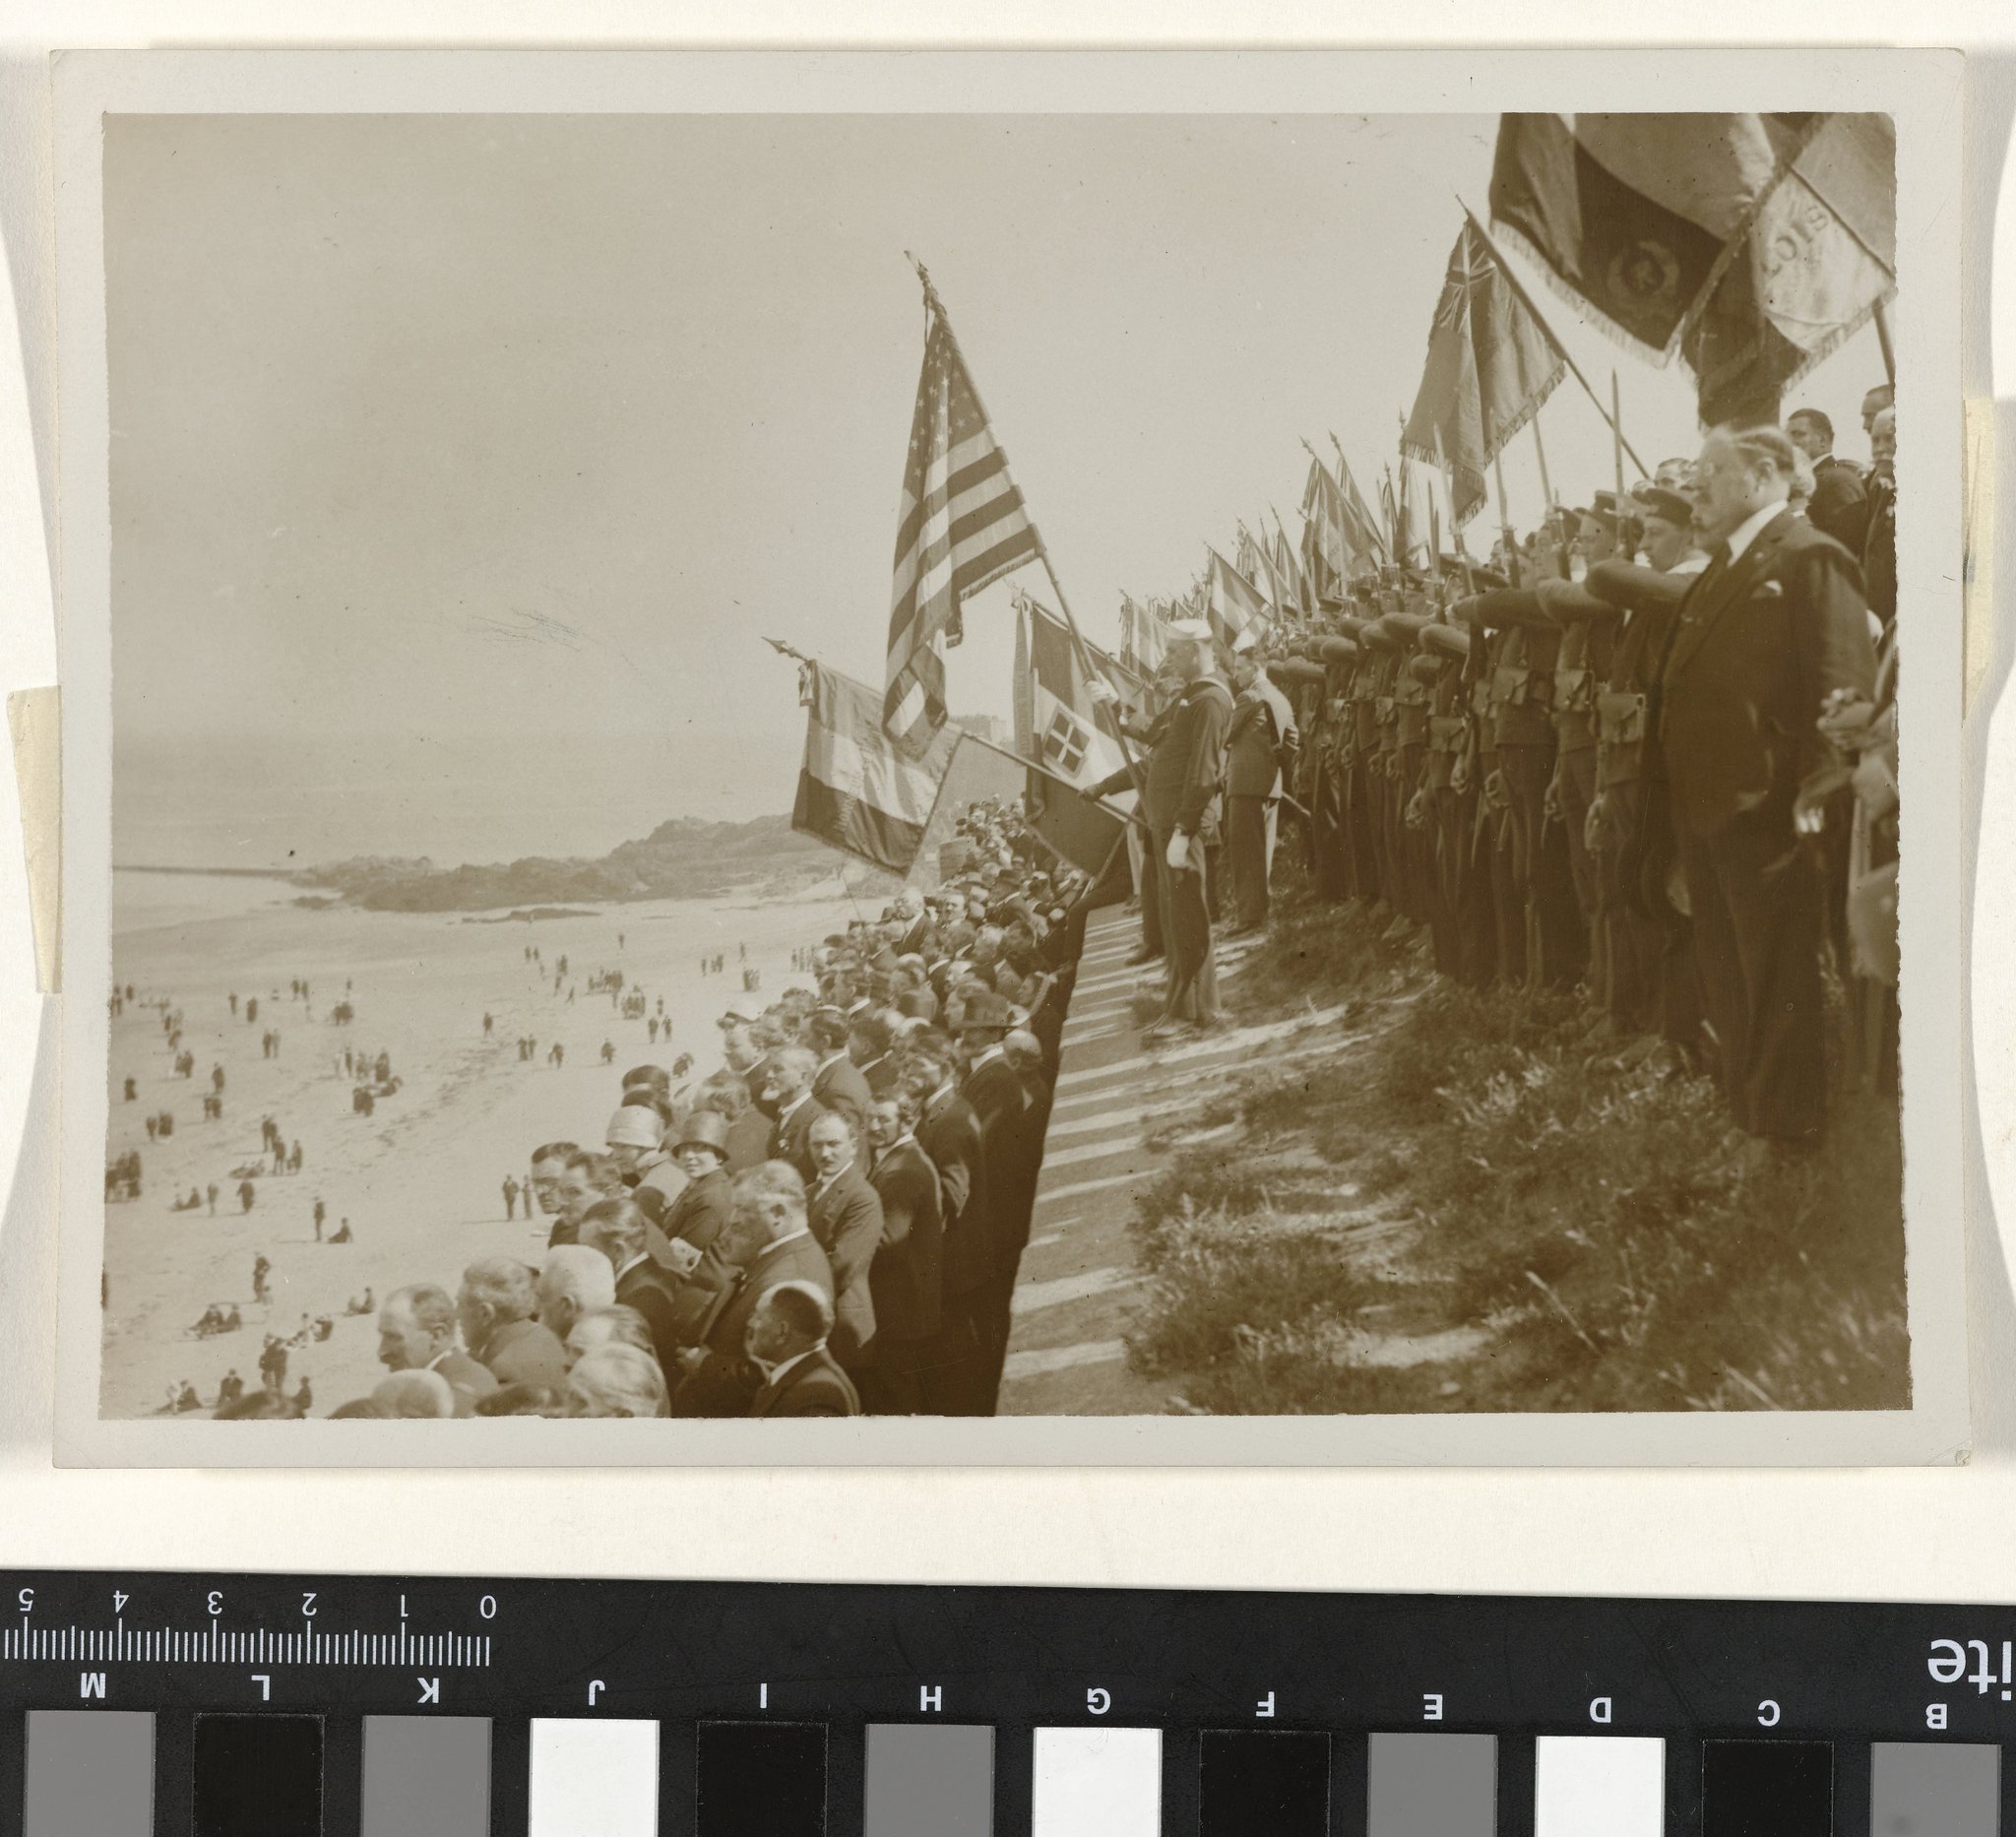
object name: photograph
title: Lesw Fêtes du Congrès des Anciens Combattants à Saint-Malo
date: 1920-1939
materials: paper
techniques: gelatin silver print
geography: saint-malo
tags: reunion, memorial gathering (~ veteran soldiers), saluting with flag, beach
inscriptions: inscription: ‘Au cours d'une émouvante cérémonie (...)à Saint-Malo.’, stamp: ‘COPYRIGHT/ KEYSTONE VIEW Co/ 100, Rue Richelieu/ (Le Journal)/ PARIS/ Tél CENTRAL 4964’